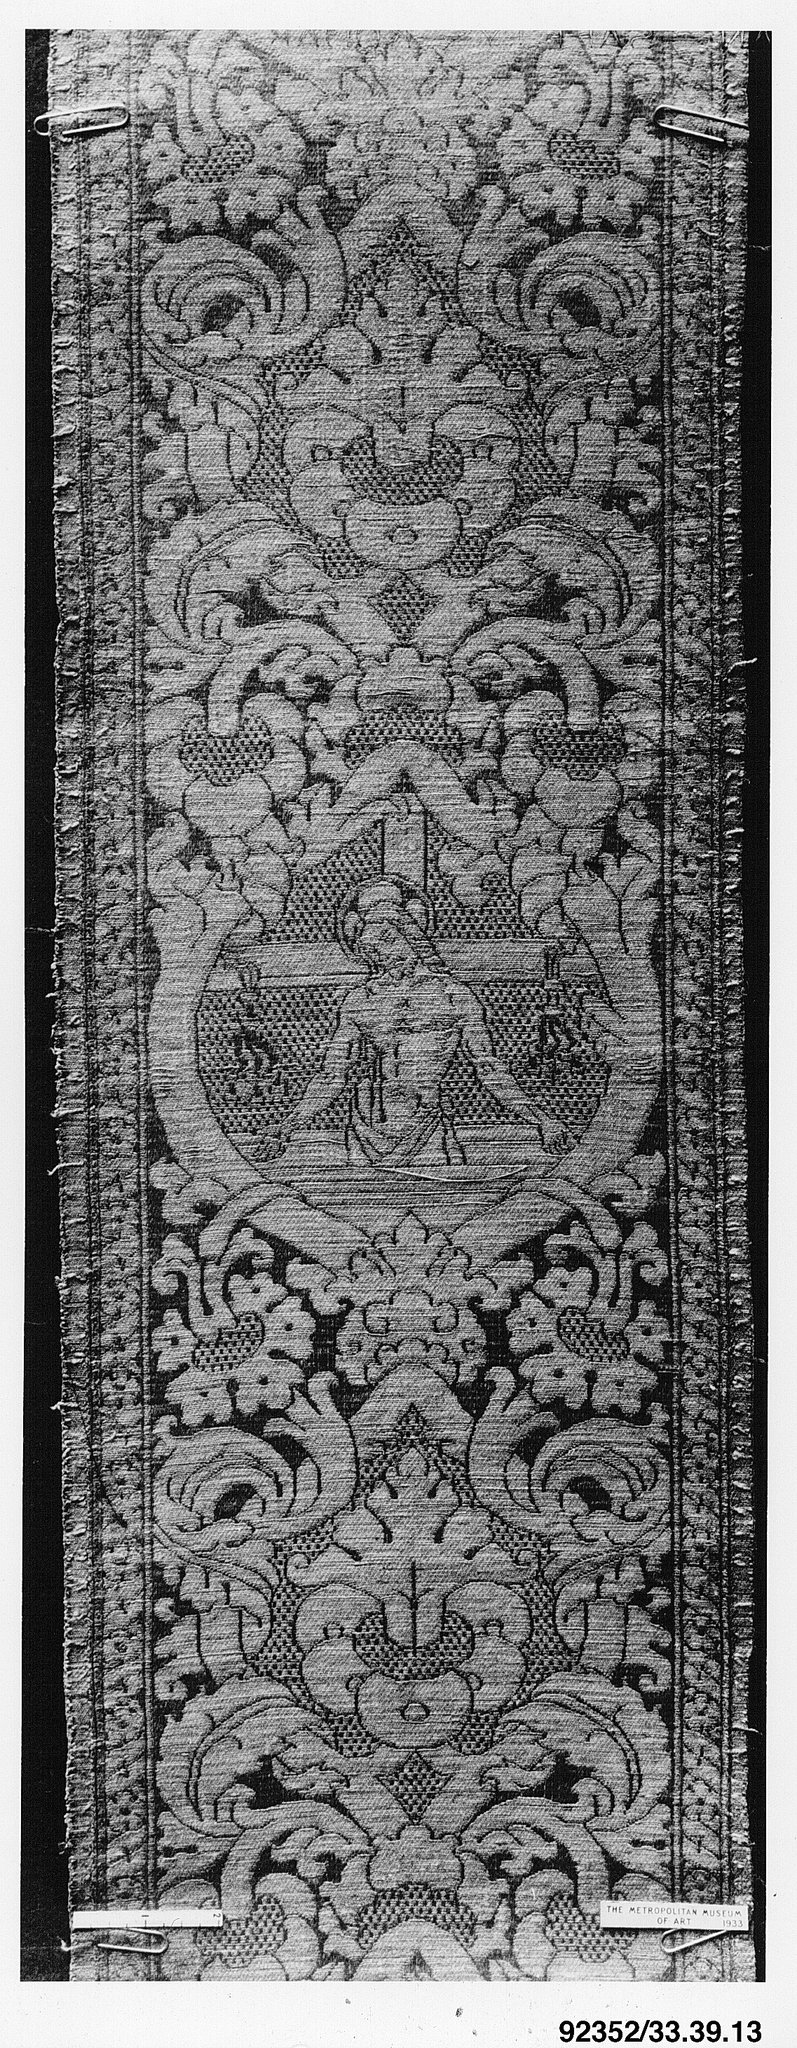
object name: orphrey fragment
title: Orphrey woven with figurative repeat design of Christ as Man of Sorrows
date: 1501-1600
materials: linen, metal thread, silk